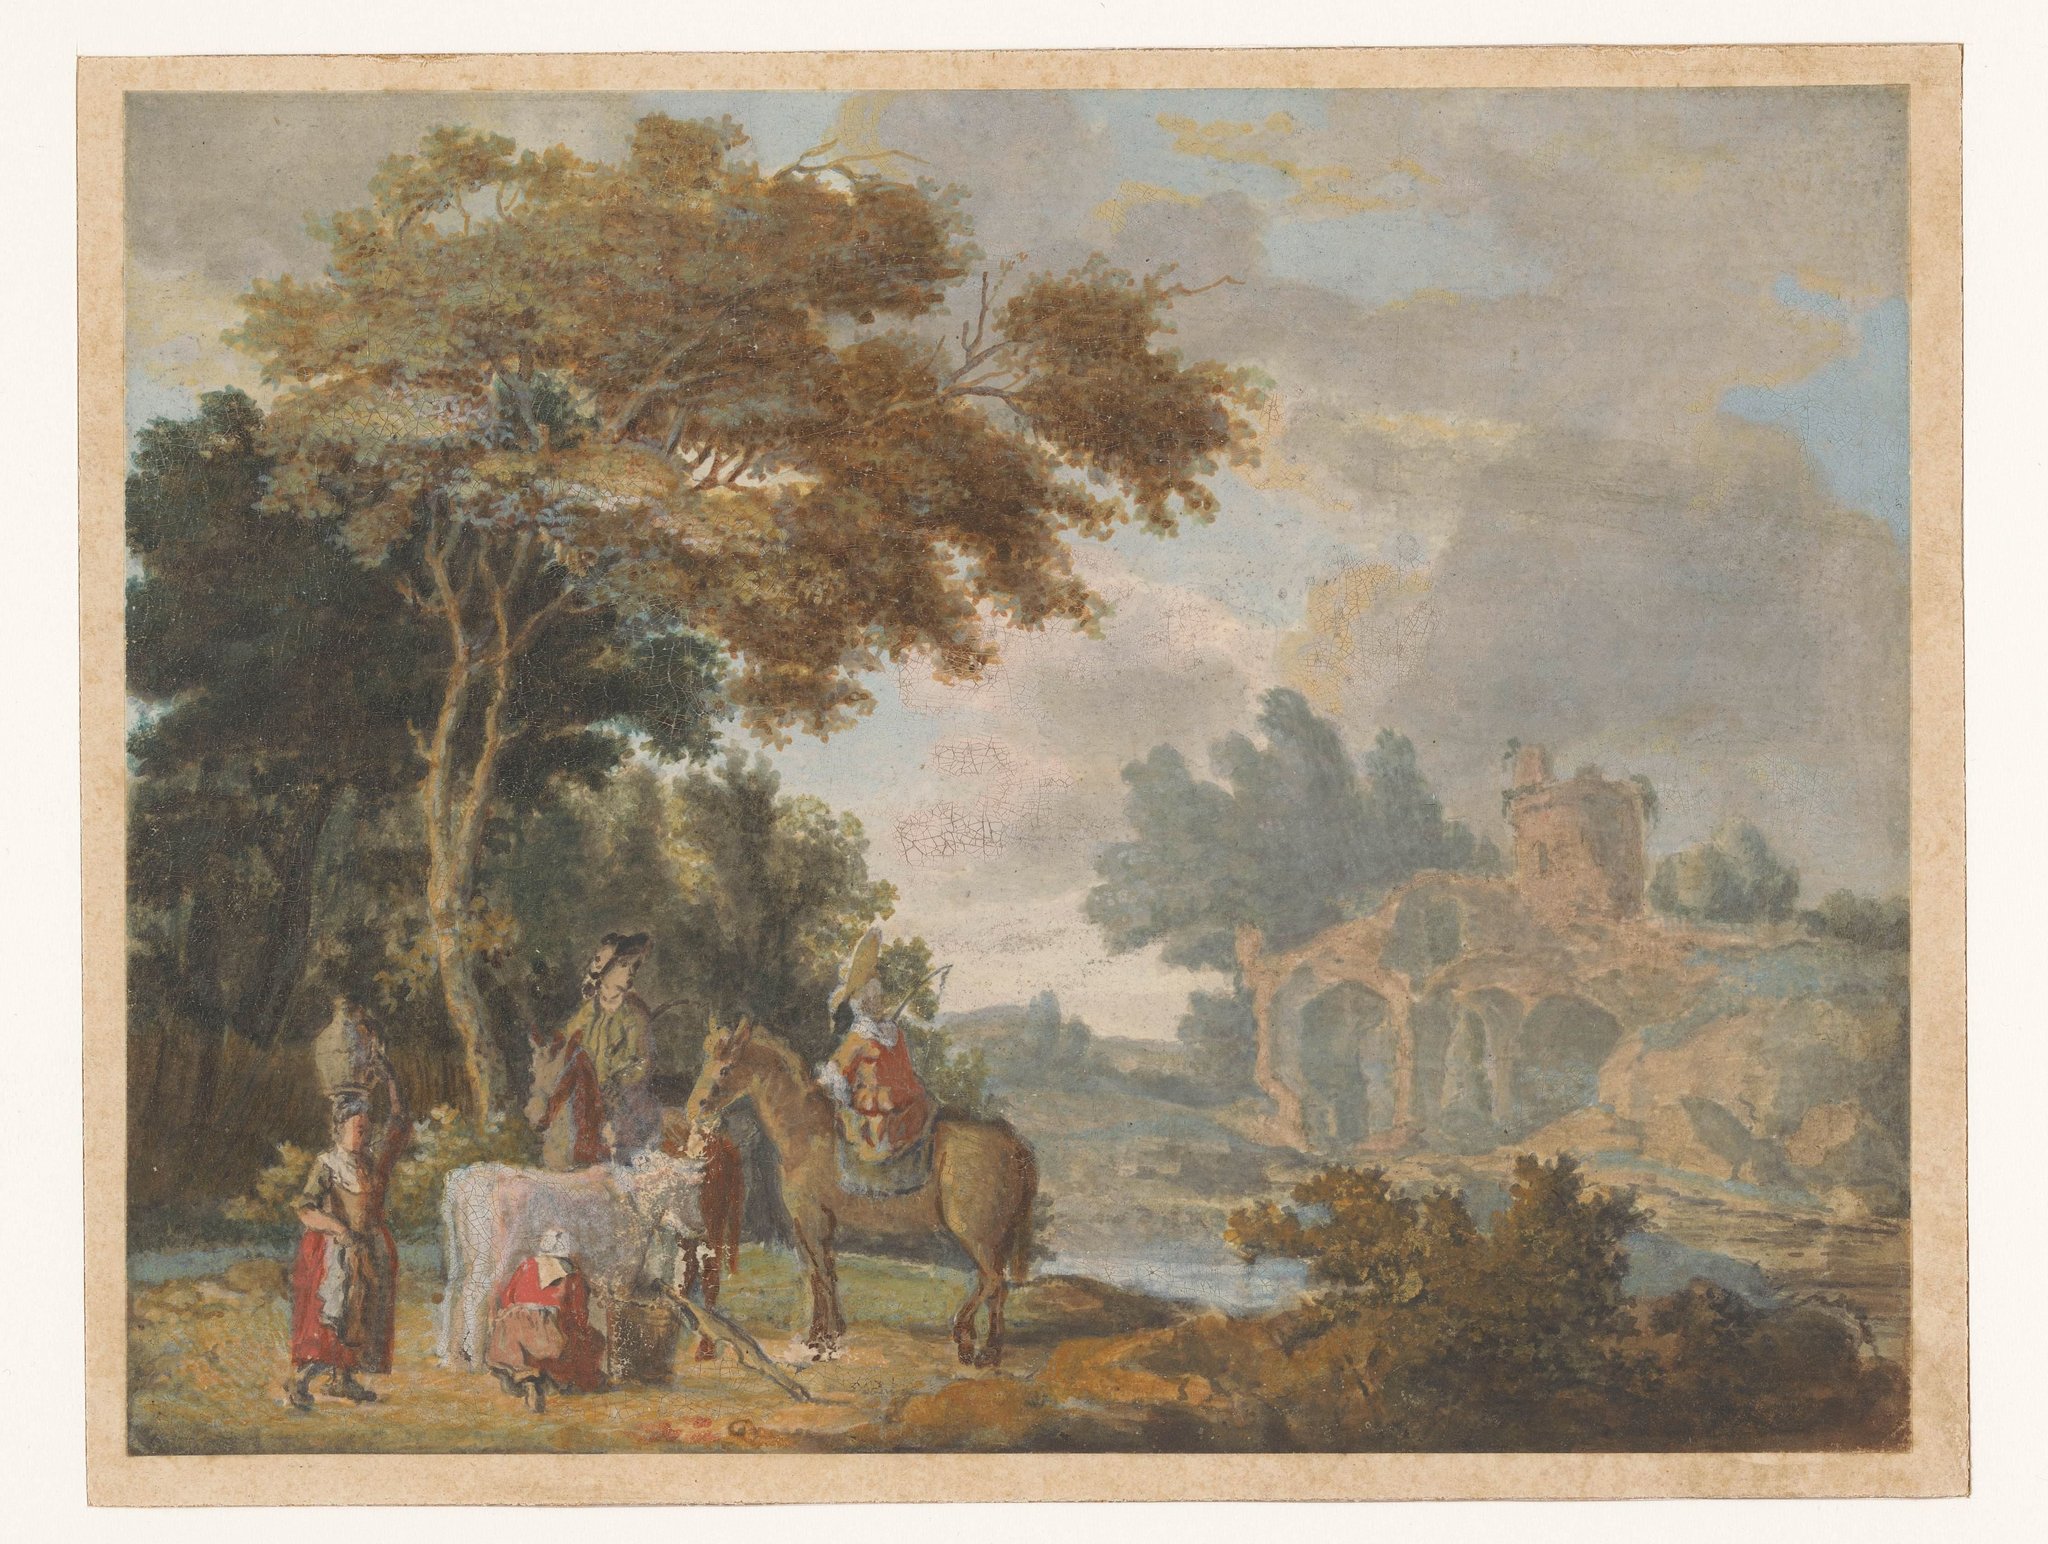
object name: drawing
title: Reizigers en landlieden in een landschap met antieke ruïnes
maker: Anonymous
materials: gouache, paper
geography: france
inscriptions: collector's mark, verso, on the mount, lower centre: Lugt 2228